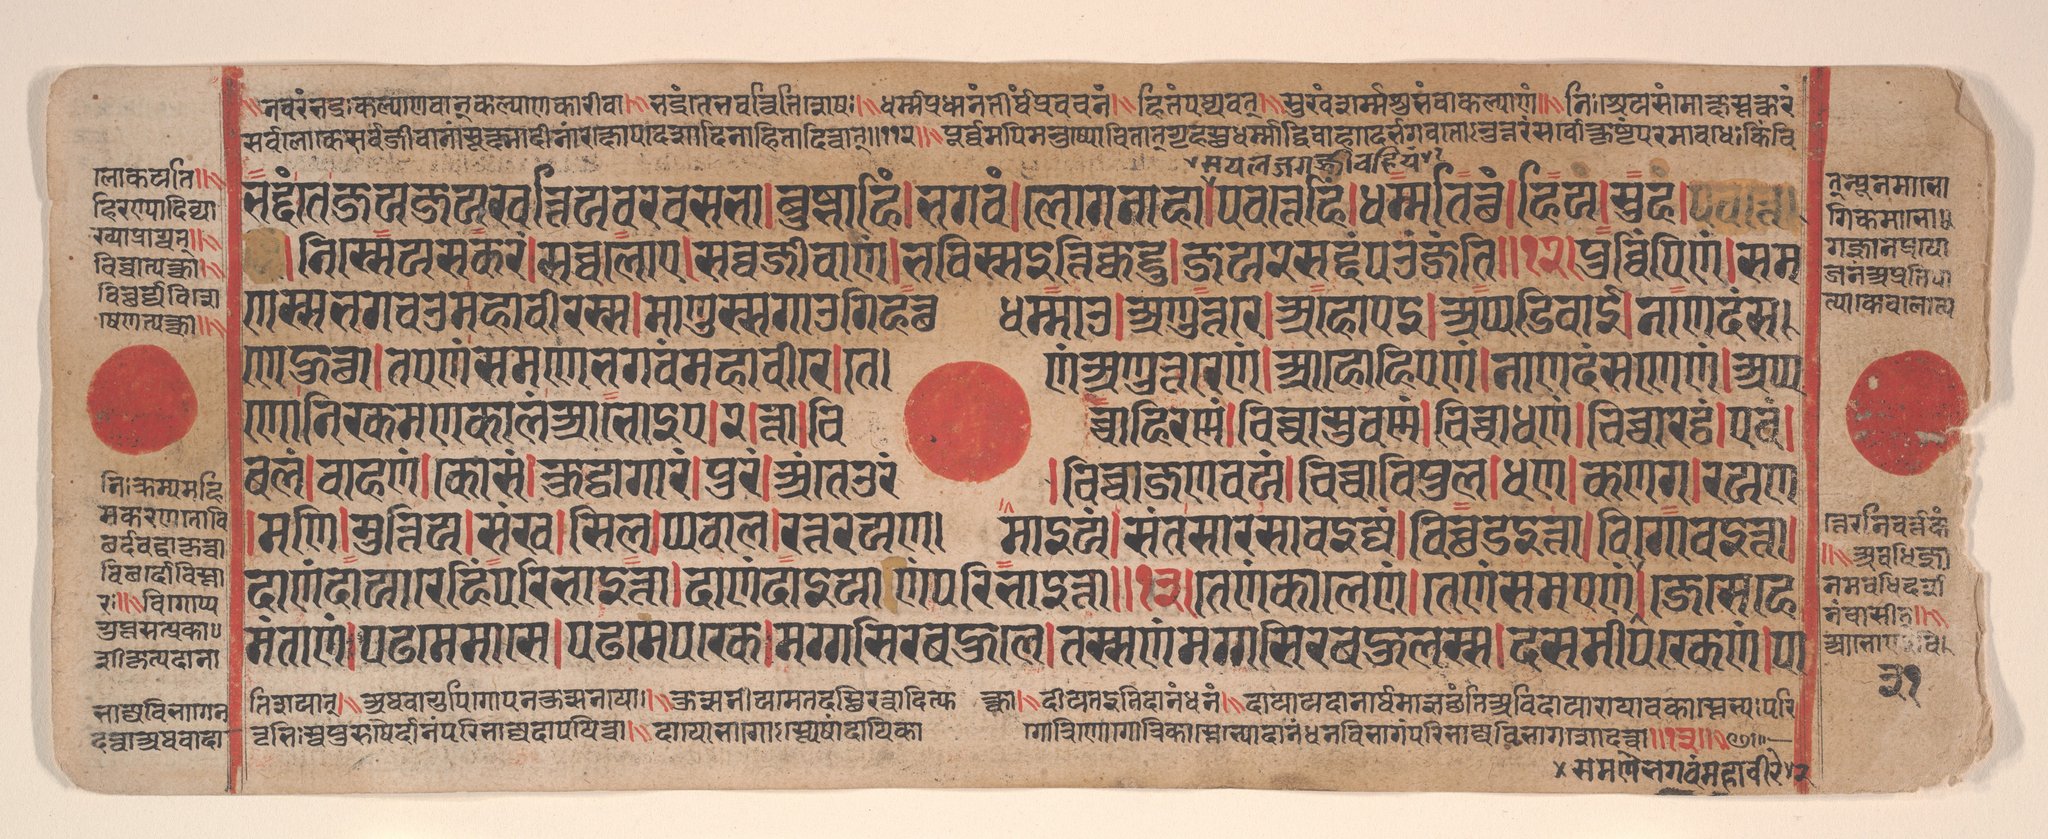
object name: folio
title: Leaf from a Kalpa Sutra (Jain Book of Rituals)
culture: indian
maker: bhadrabahu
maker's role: artist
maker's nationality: indian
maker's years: 356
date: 1401-1500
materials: gold, ink, paper, watercolor